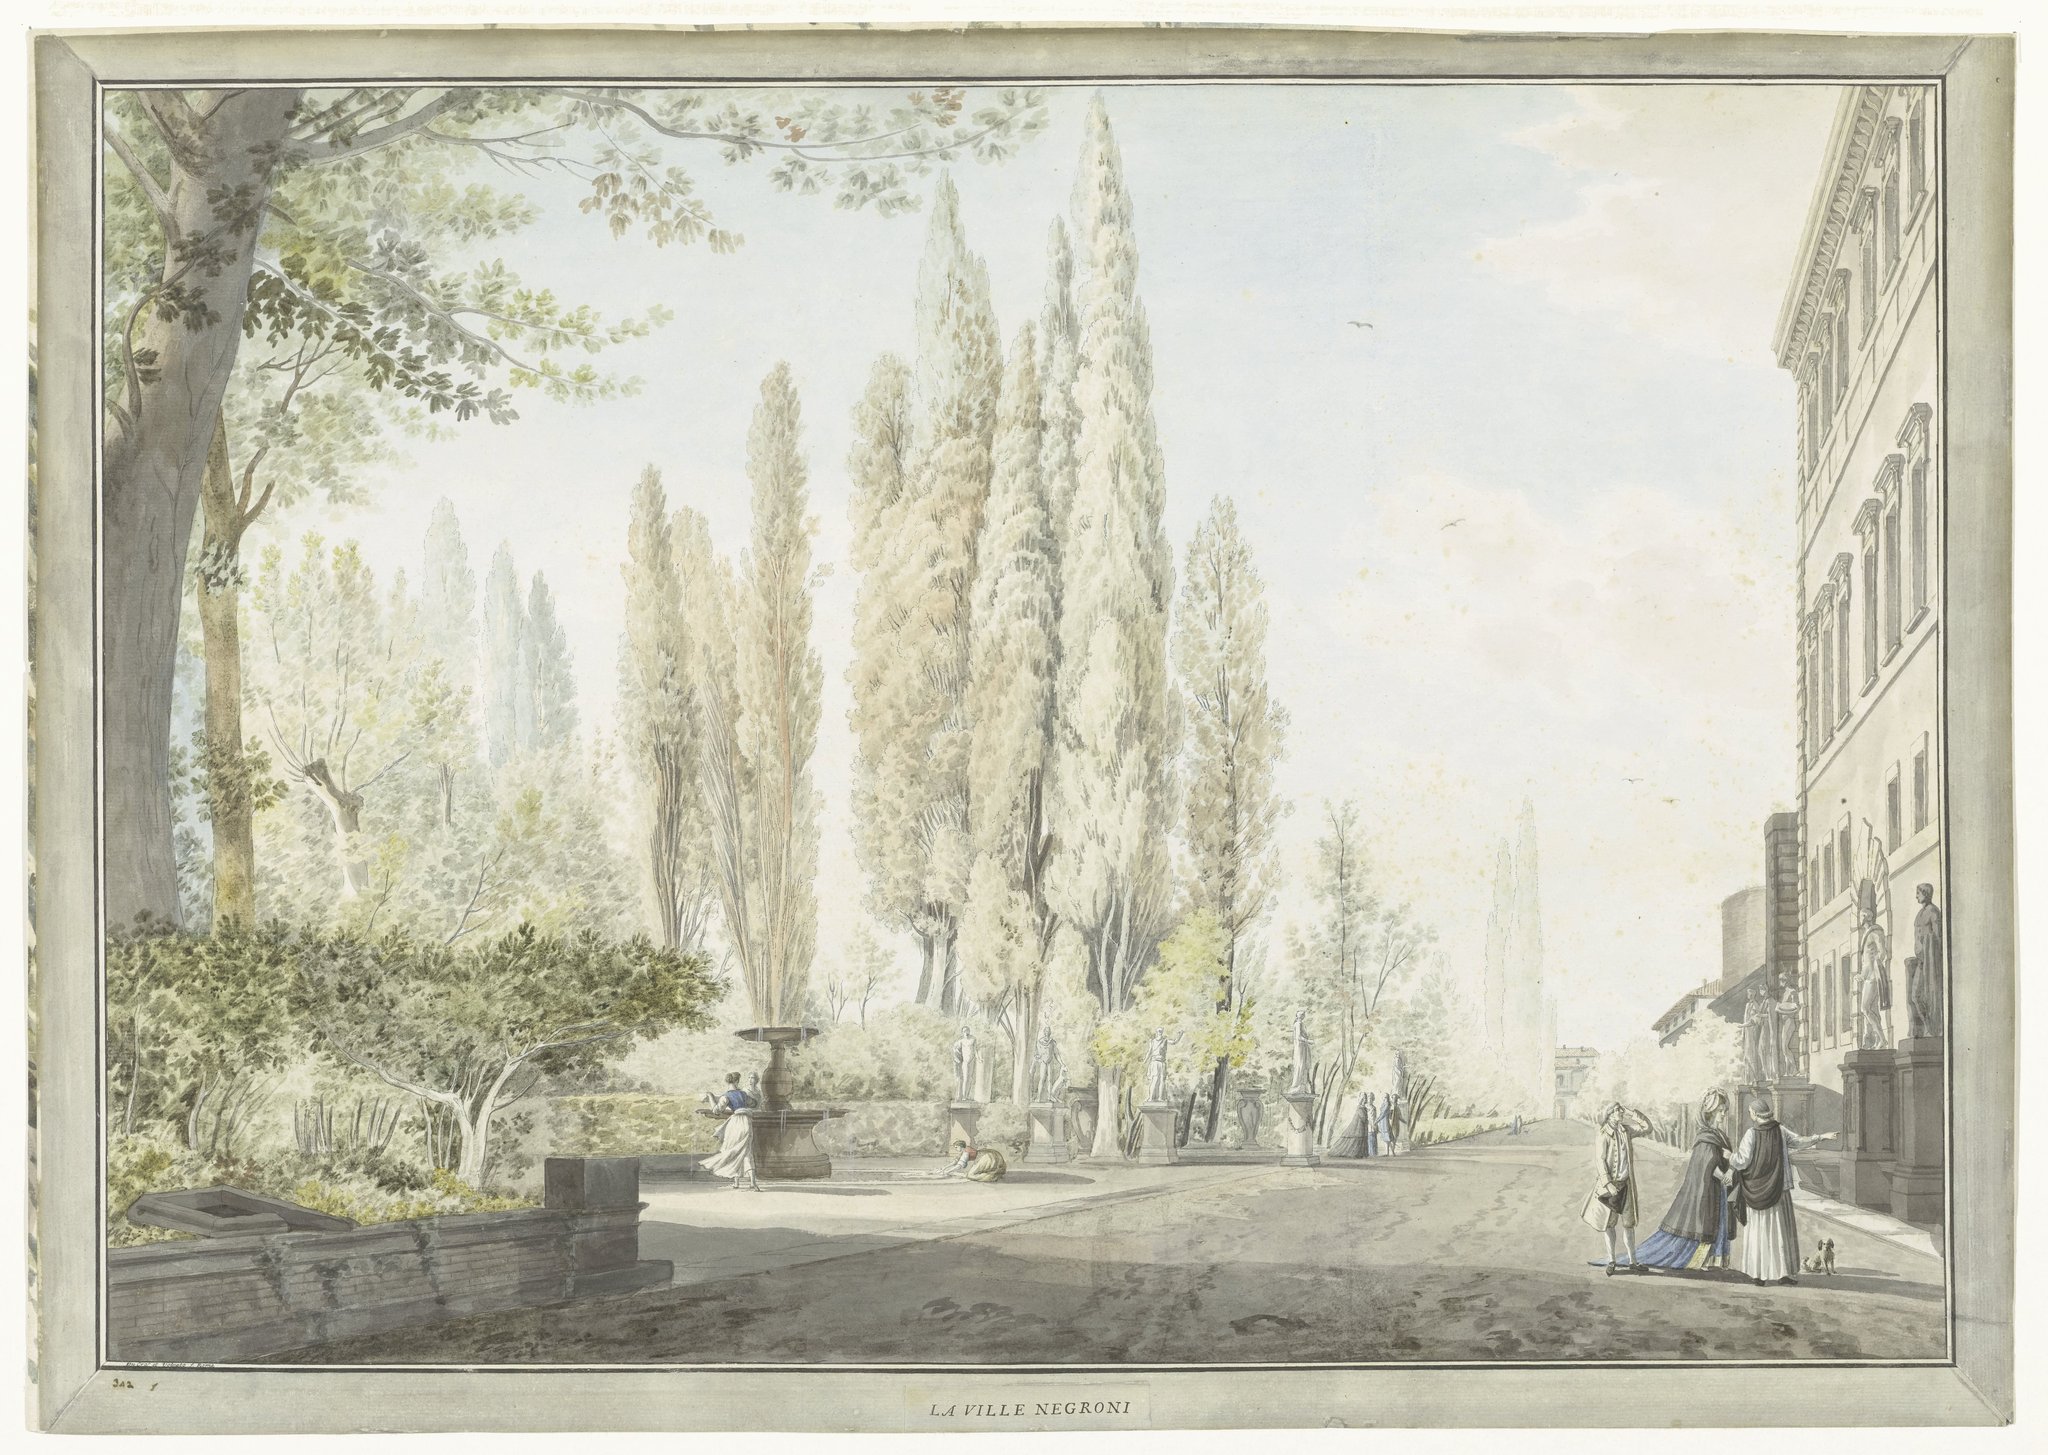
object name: print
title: Gezichten op Rome en omgeving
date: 1758-1803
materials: paper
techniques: colour, etching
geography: italy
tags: city-view, and landscape with man-made constructions, villa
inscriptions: collector's mark: Lugt 2228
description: Prent is voorzien van een rand van papier met kader in pen in zwart. Deze prent maakt deel uit van een serie van 40 prenten met gezichten op Rome en omgeving.